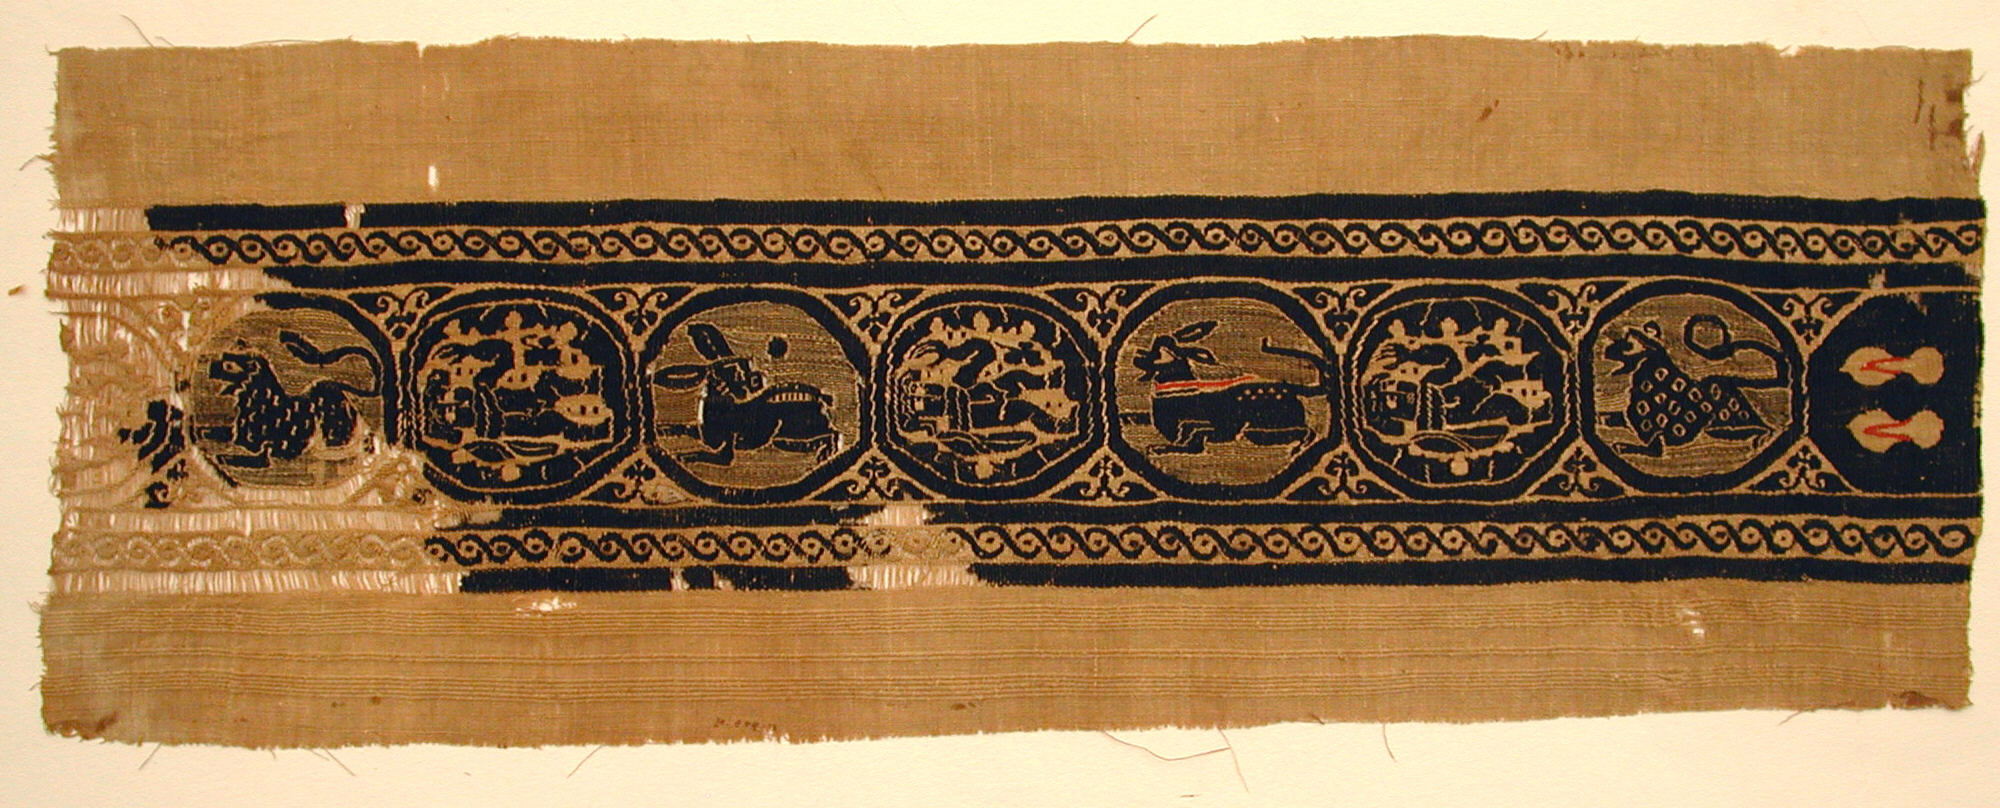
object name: textile fragment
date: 301-400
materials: linen, wool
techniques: weave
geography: egypt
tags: animals